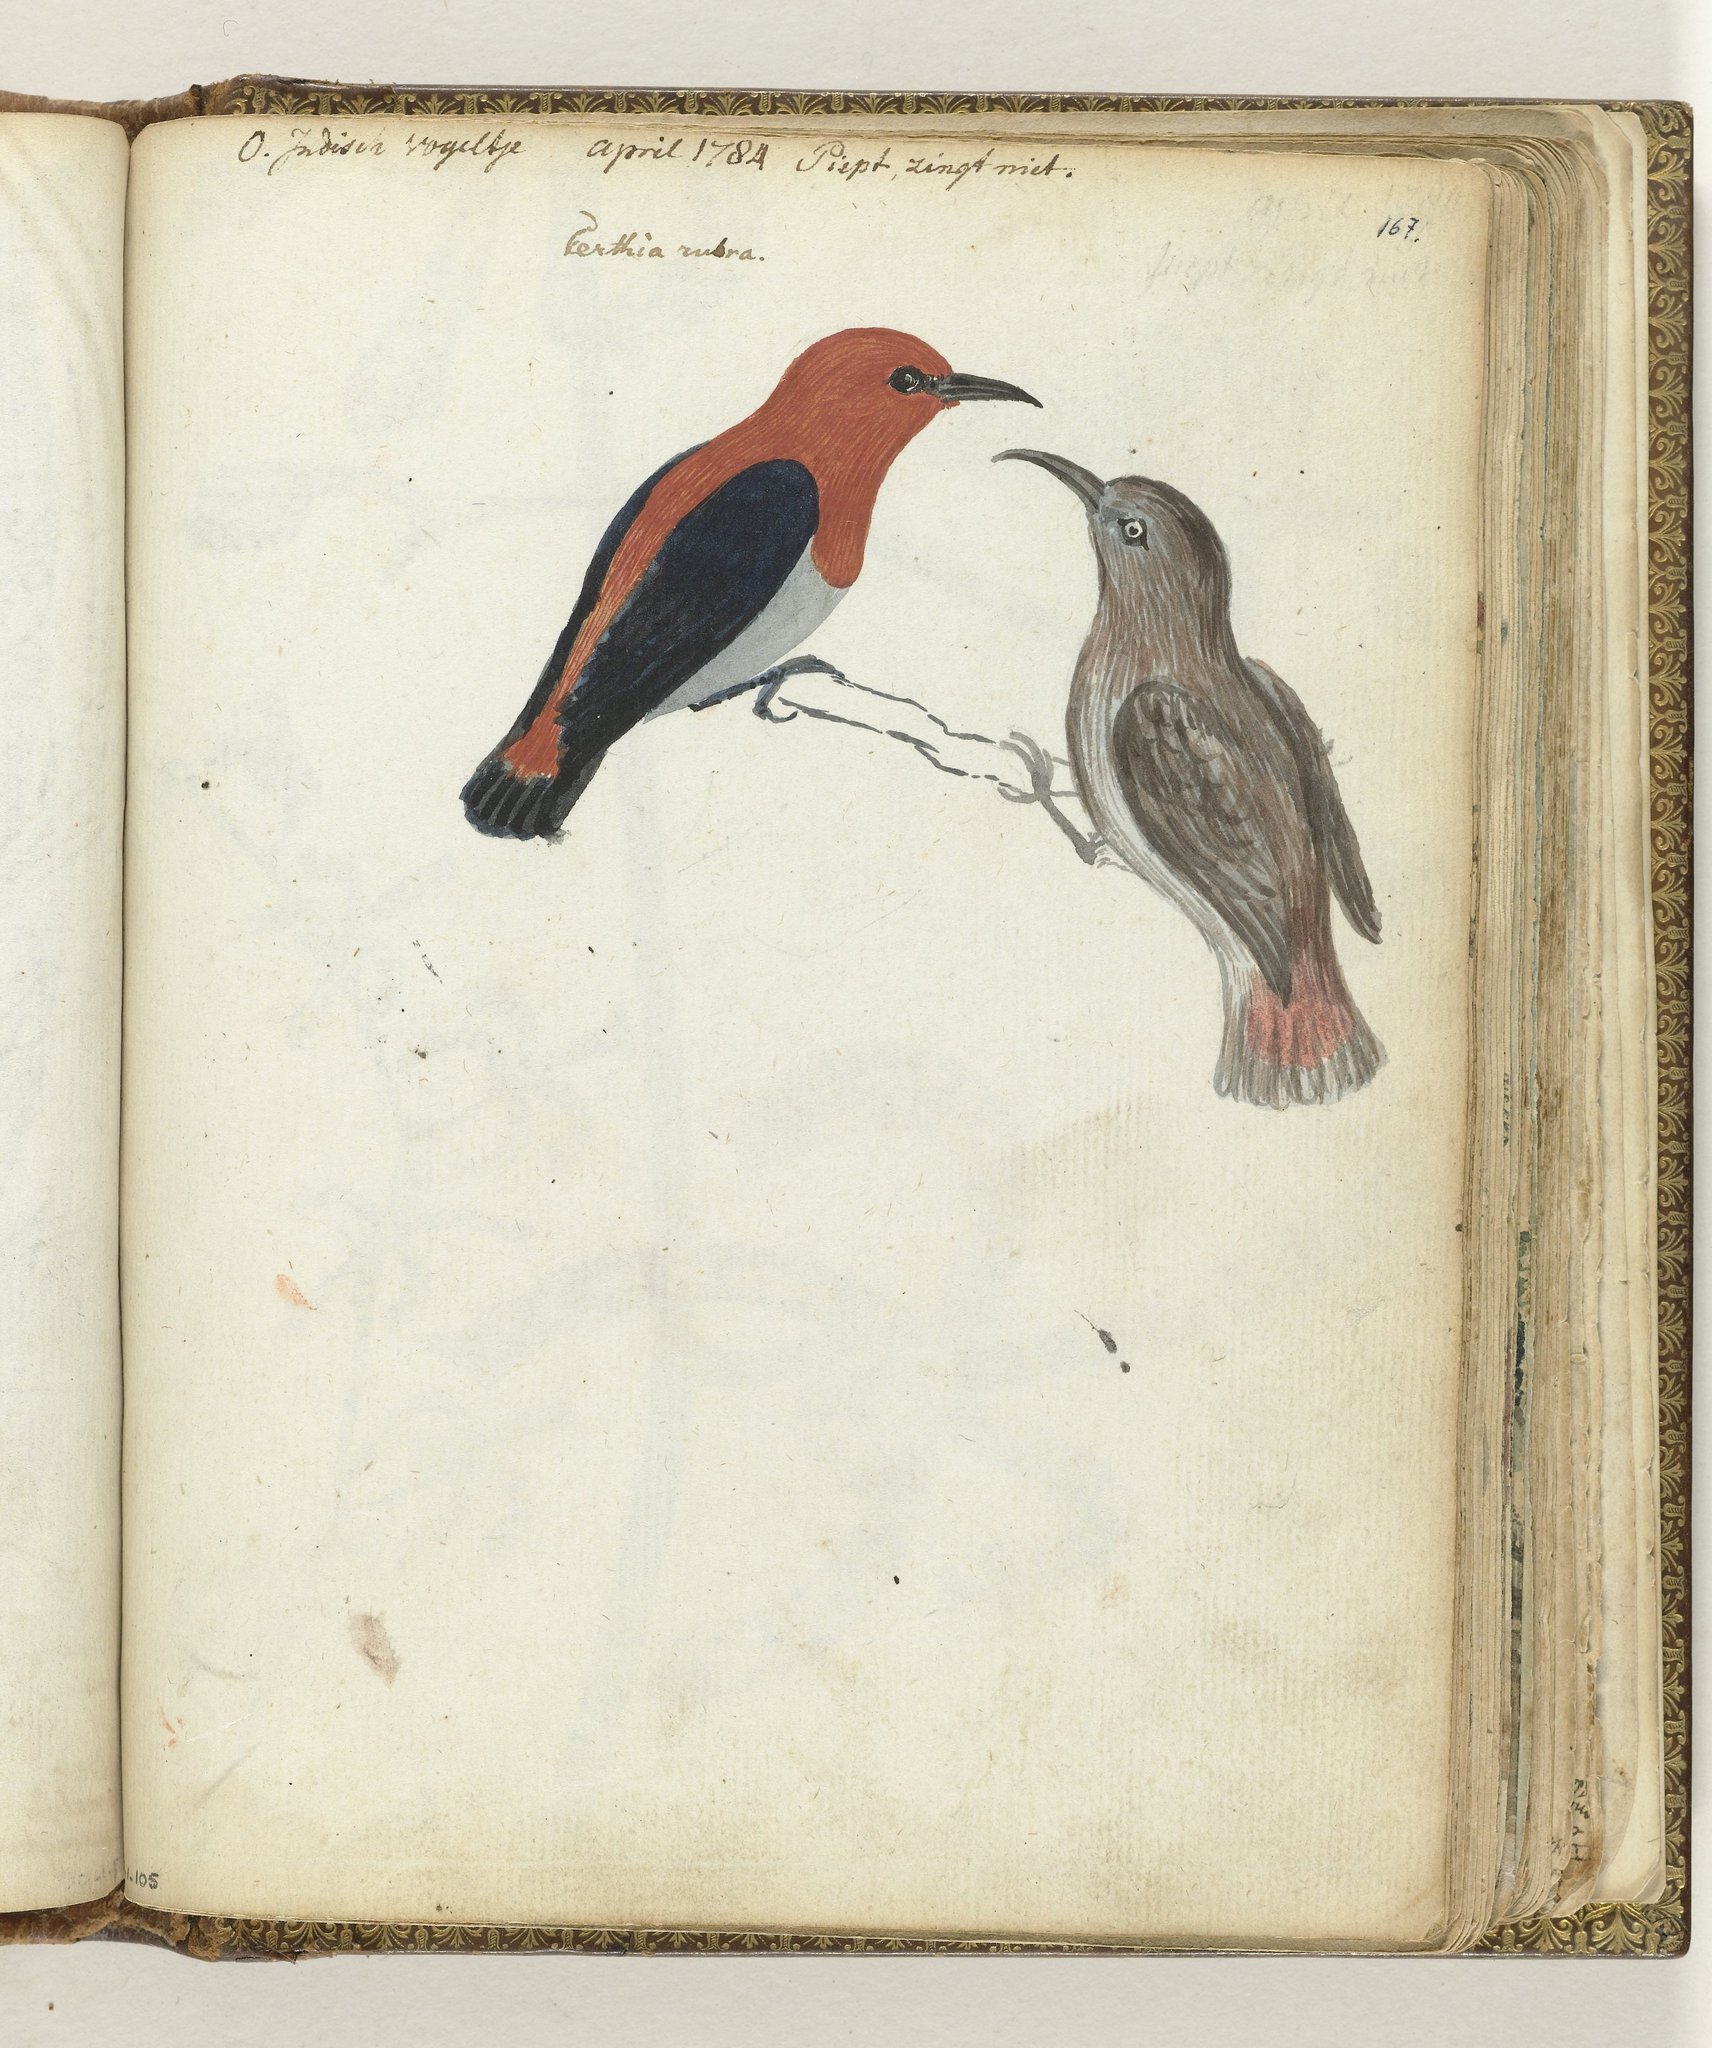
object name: drawing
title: Javaanse vogels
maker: jan brandes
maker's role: draughtsman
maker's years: 1743-1808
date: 1704-1784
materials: paper, pencil, watercolor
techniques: brush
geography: jakarta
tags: birds, indonesia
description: Kleurtekening van twee vogels. Met opschrift. Onderdeel uit het schetsboek van Jan Brandes, dl. 1 (1808), p. 167.